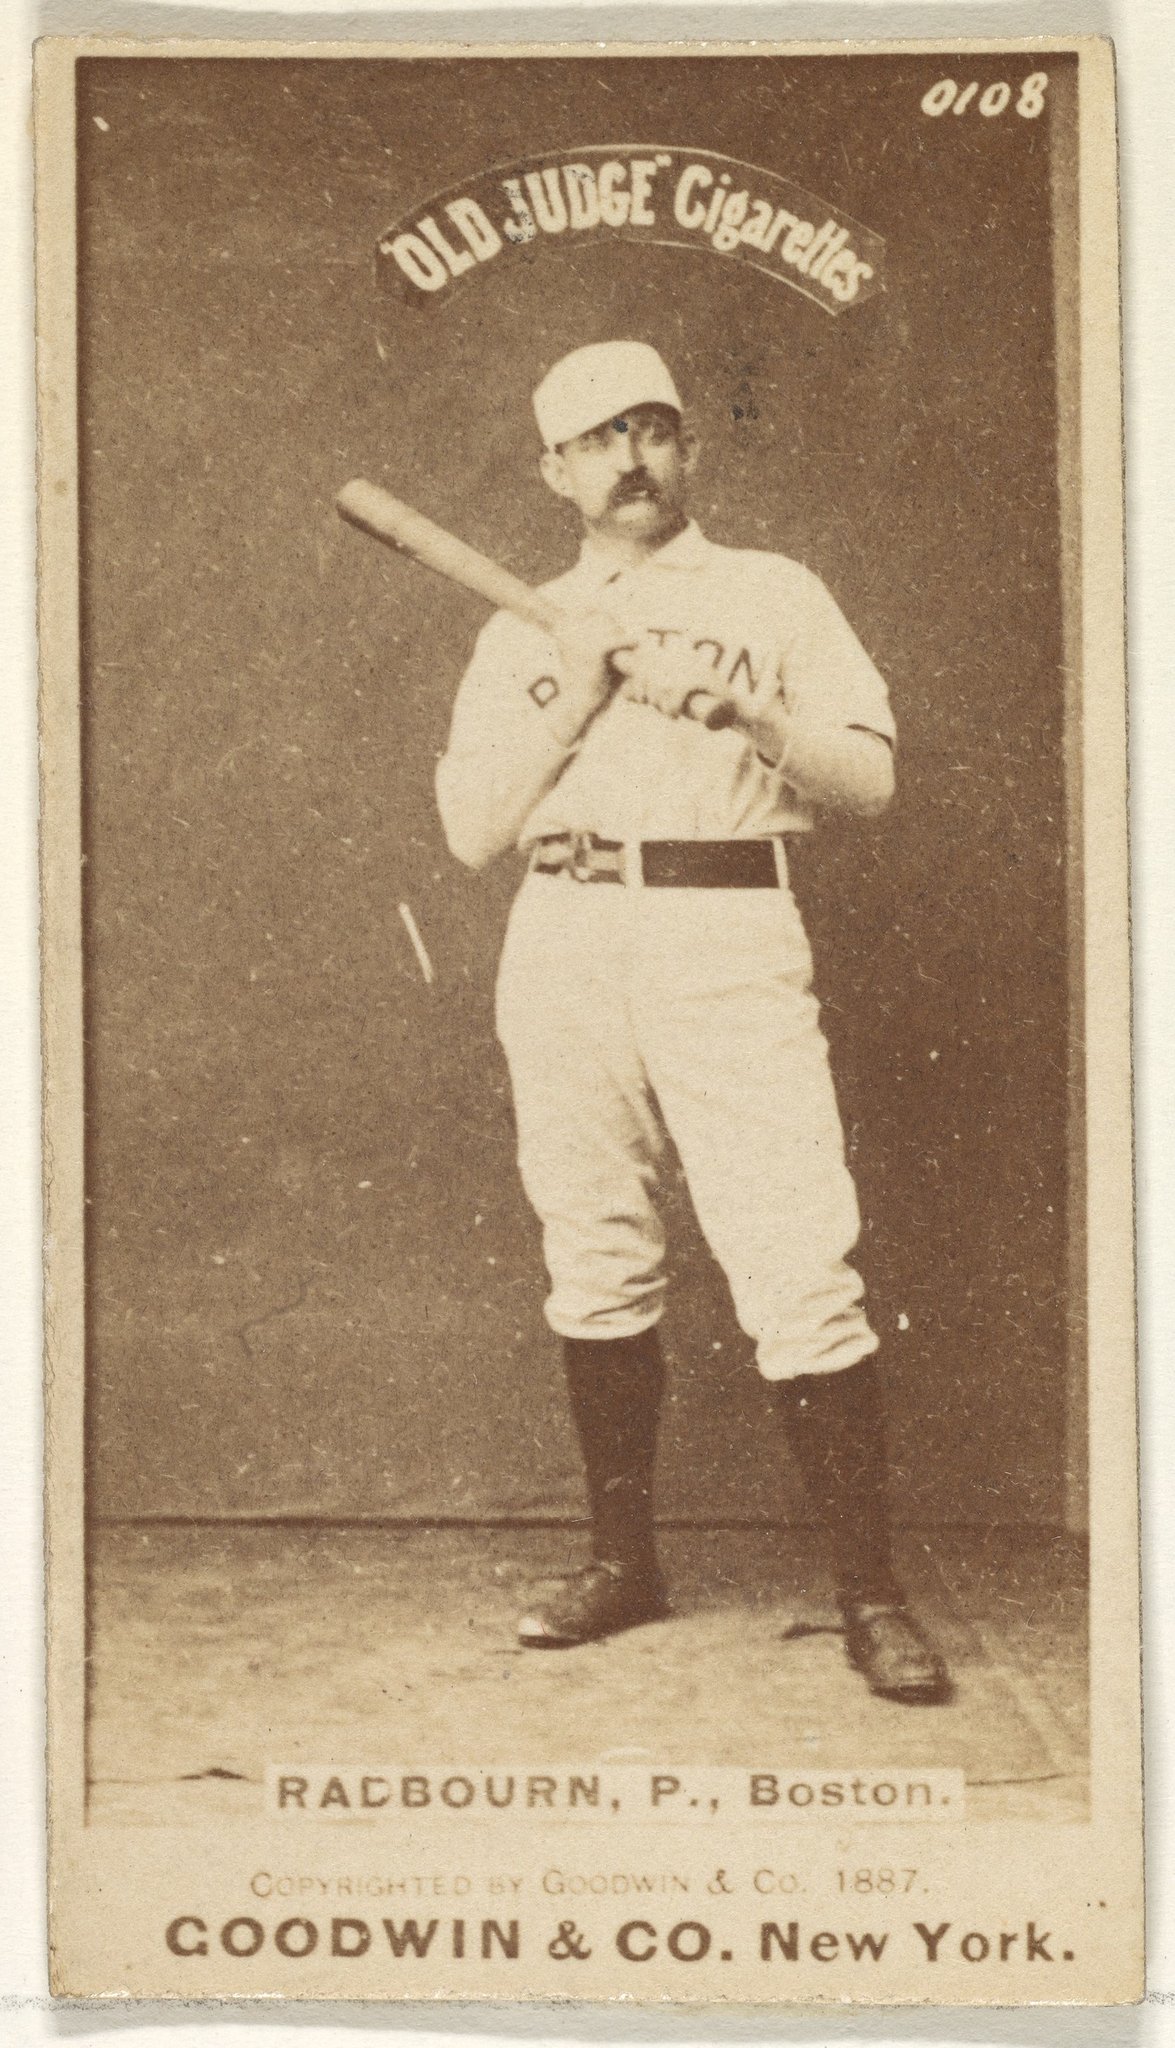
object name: baseball card, photograph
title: Radbourn, Pitcher, Boston, from the Old Judge series (N172) for Old Judge Cigarettes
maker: goodwin & company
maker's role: publisher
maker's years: 1850-1950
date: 1887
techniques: albumen silver print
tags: men,portraits,baseball,athletes